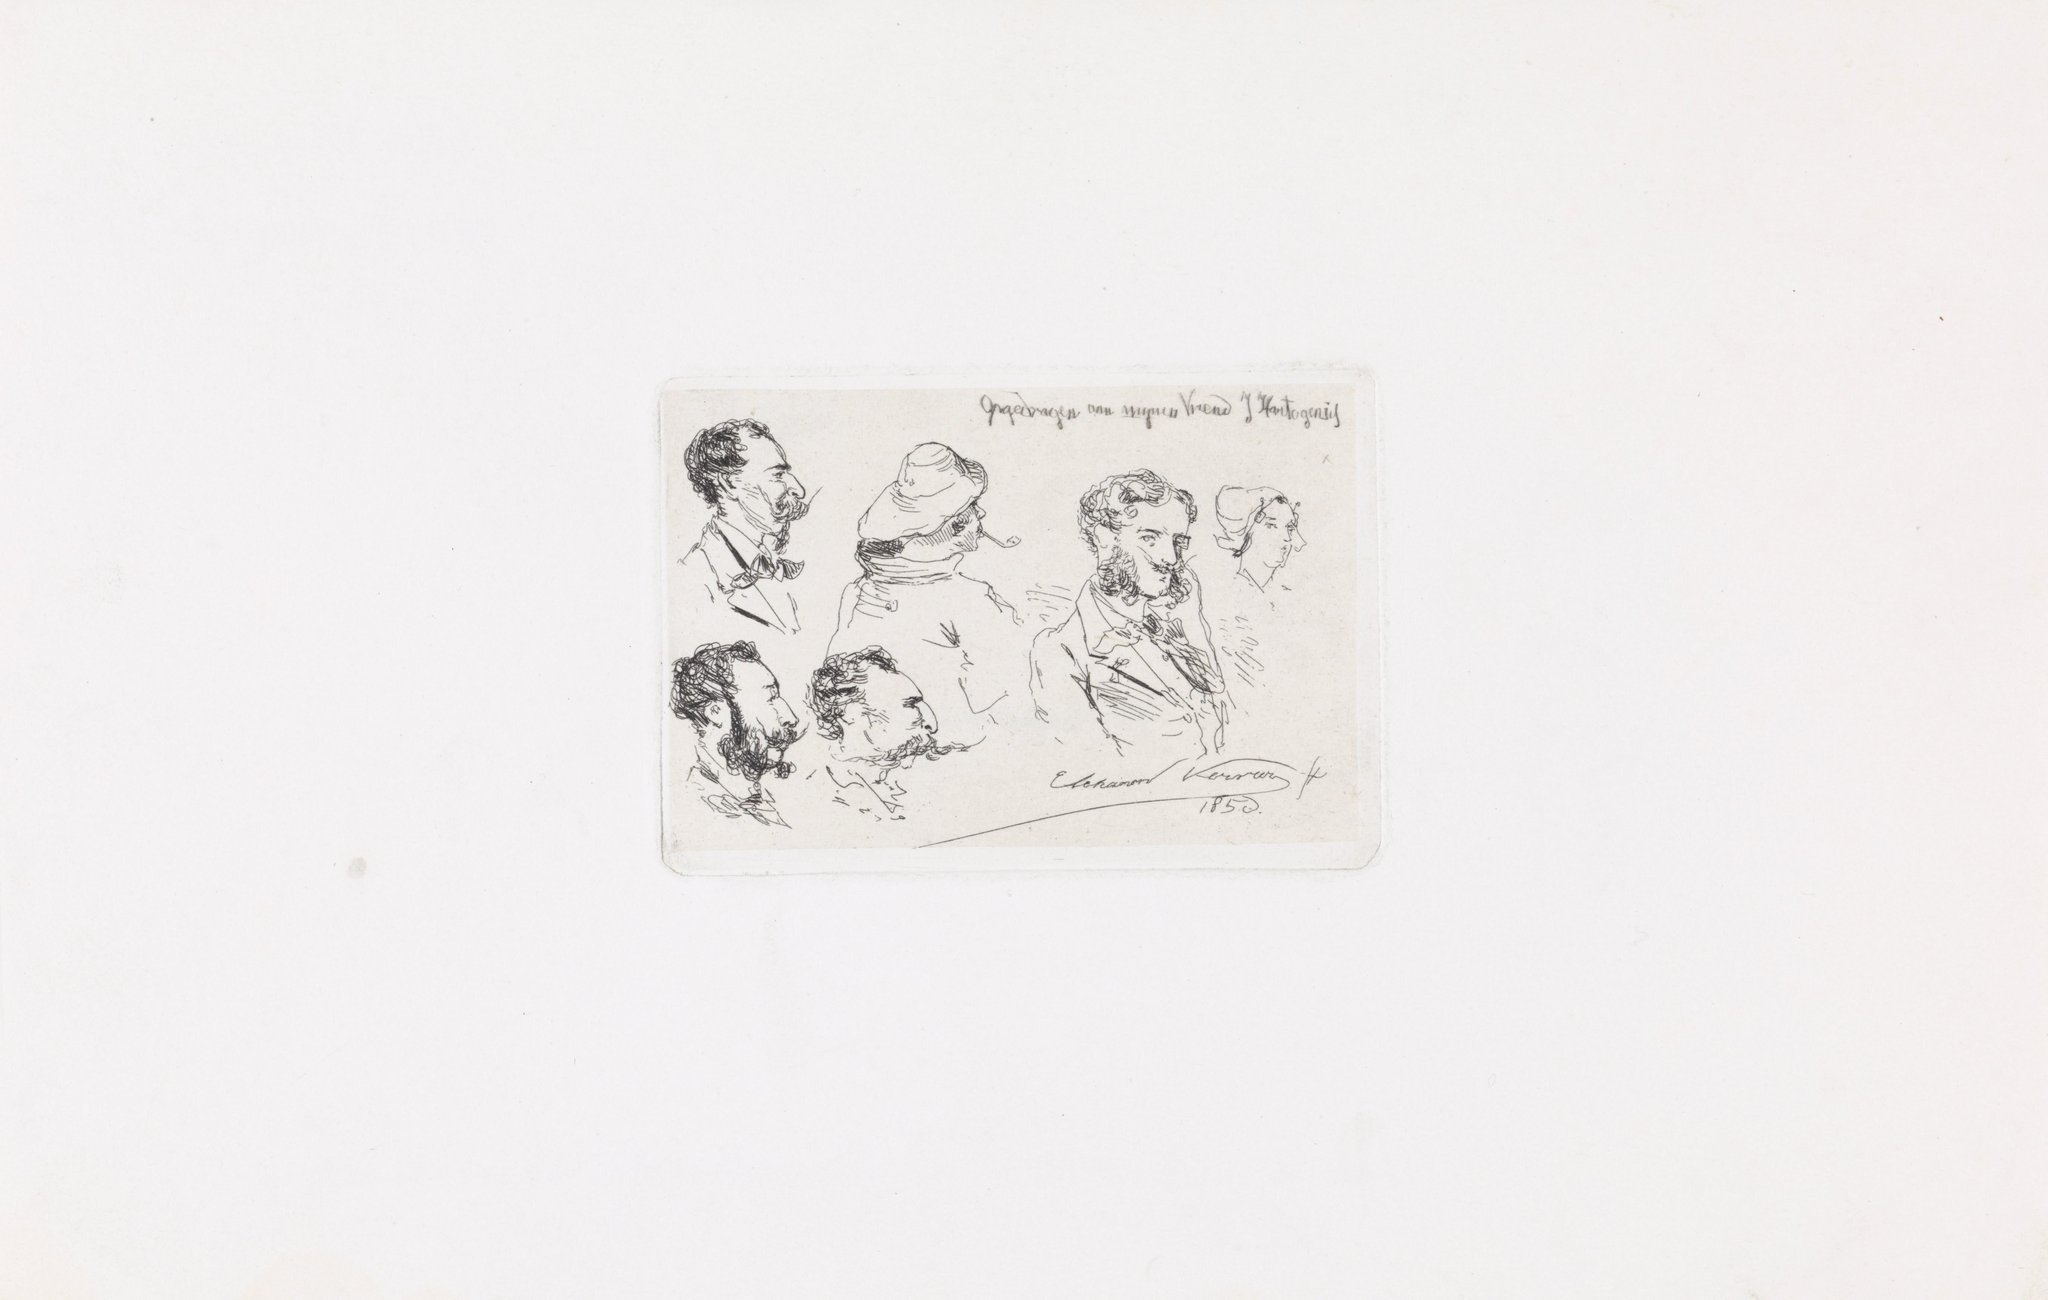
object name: print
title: Studieblad met zes koppen, waaronder de portretten van de broers Verveer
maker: elchanon verveer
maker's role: draughtsman, print maker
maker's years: 1826-1900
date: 1856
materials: paper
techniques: etching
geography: the hague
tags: the hague, salomon leonardus verveer, print maker, draughtsman, elchanon verveer, maurits verveer, moustache, farmers - aa - female farmer, farmer's wife, fisherman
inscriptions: collector's mark: Lugt 2228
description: Studieblad met vier koppen van heren met snorren, een kop van een visser en een kop van een boerin. Linksboven het portret van Elchanon Verveer, linksonder het portret van Maurits Verveer en rechts daarnaast het portret van Samuel Verveer.